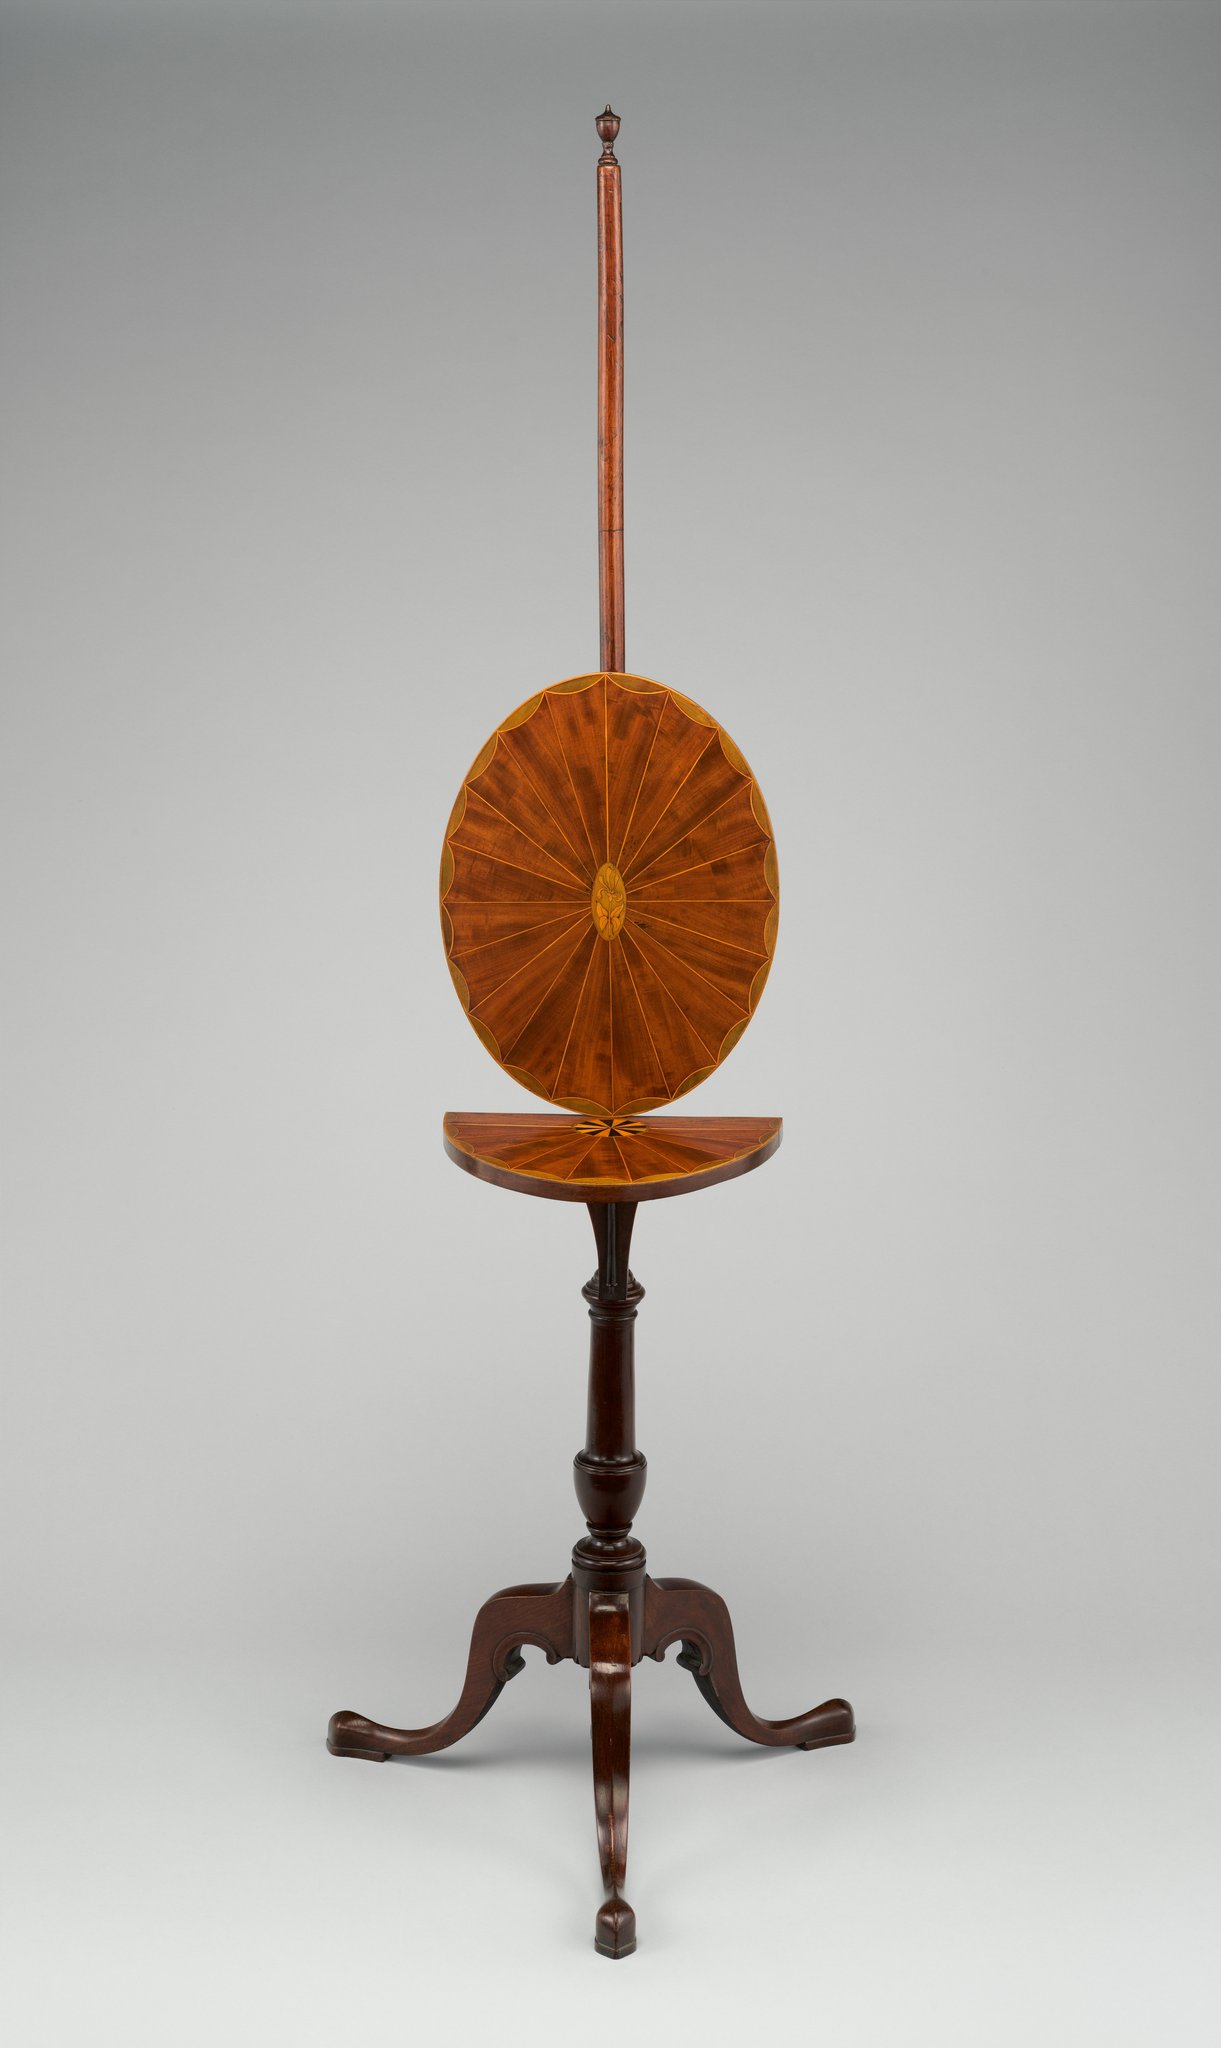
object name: firescreen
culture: american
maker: samuel phippen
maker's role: maker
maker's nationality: american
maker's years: 1741-1798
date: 1785-1795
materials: wood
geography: united states